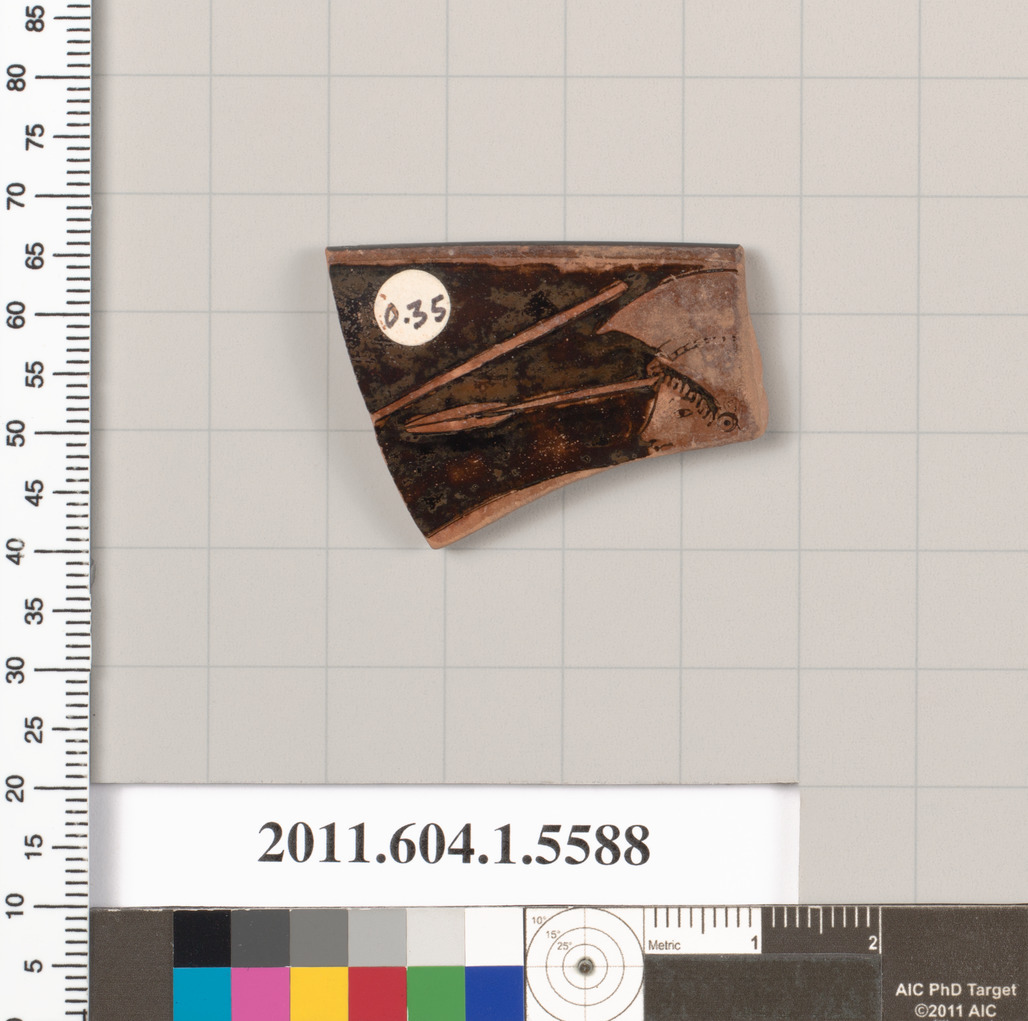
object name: kylix fragment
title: Terracotta rim fragment of a kylix (drinking cup)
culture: greek, attic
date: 510-480 BCE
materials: terracotta